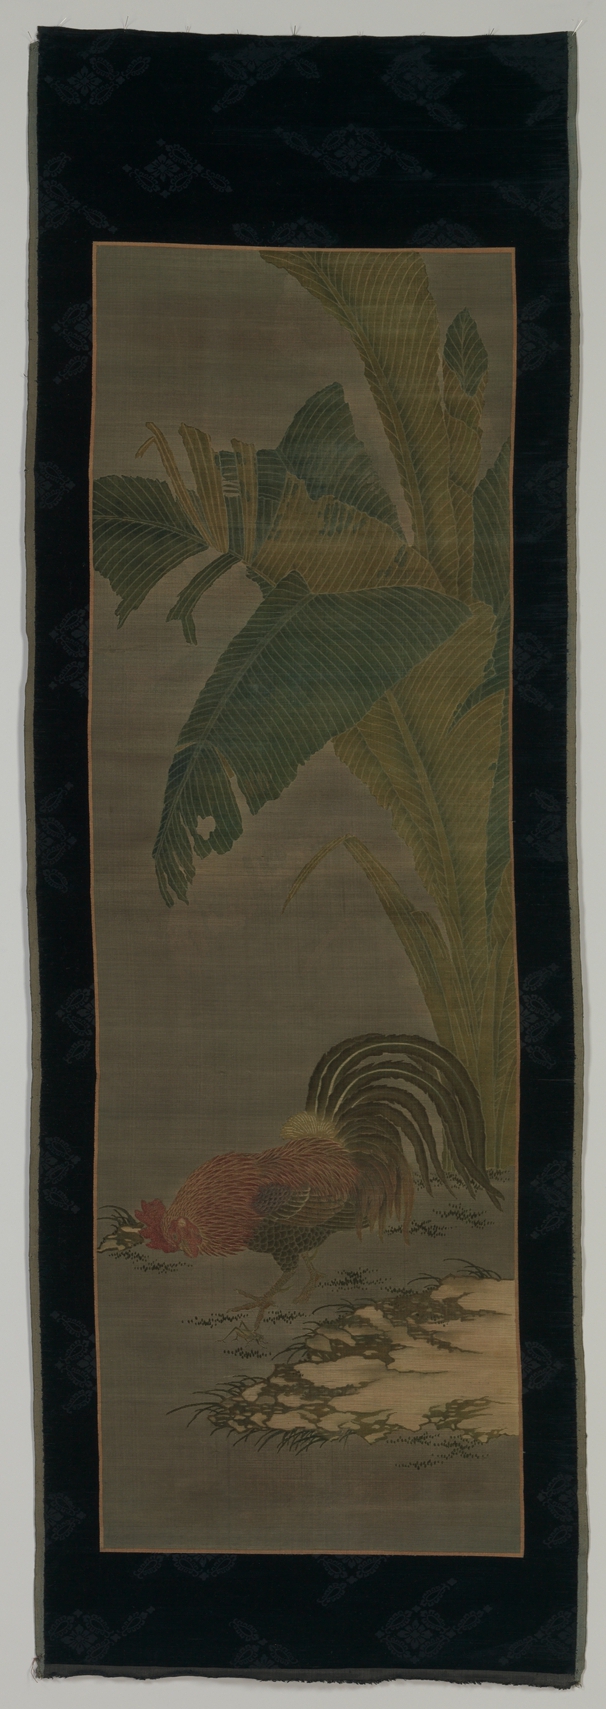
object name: panel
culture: japanese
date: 1767-1833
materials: silk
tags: roosters